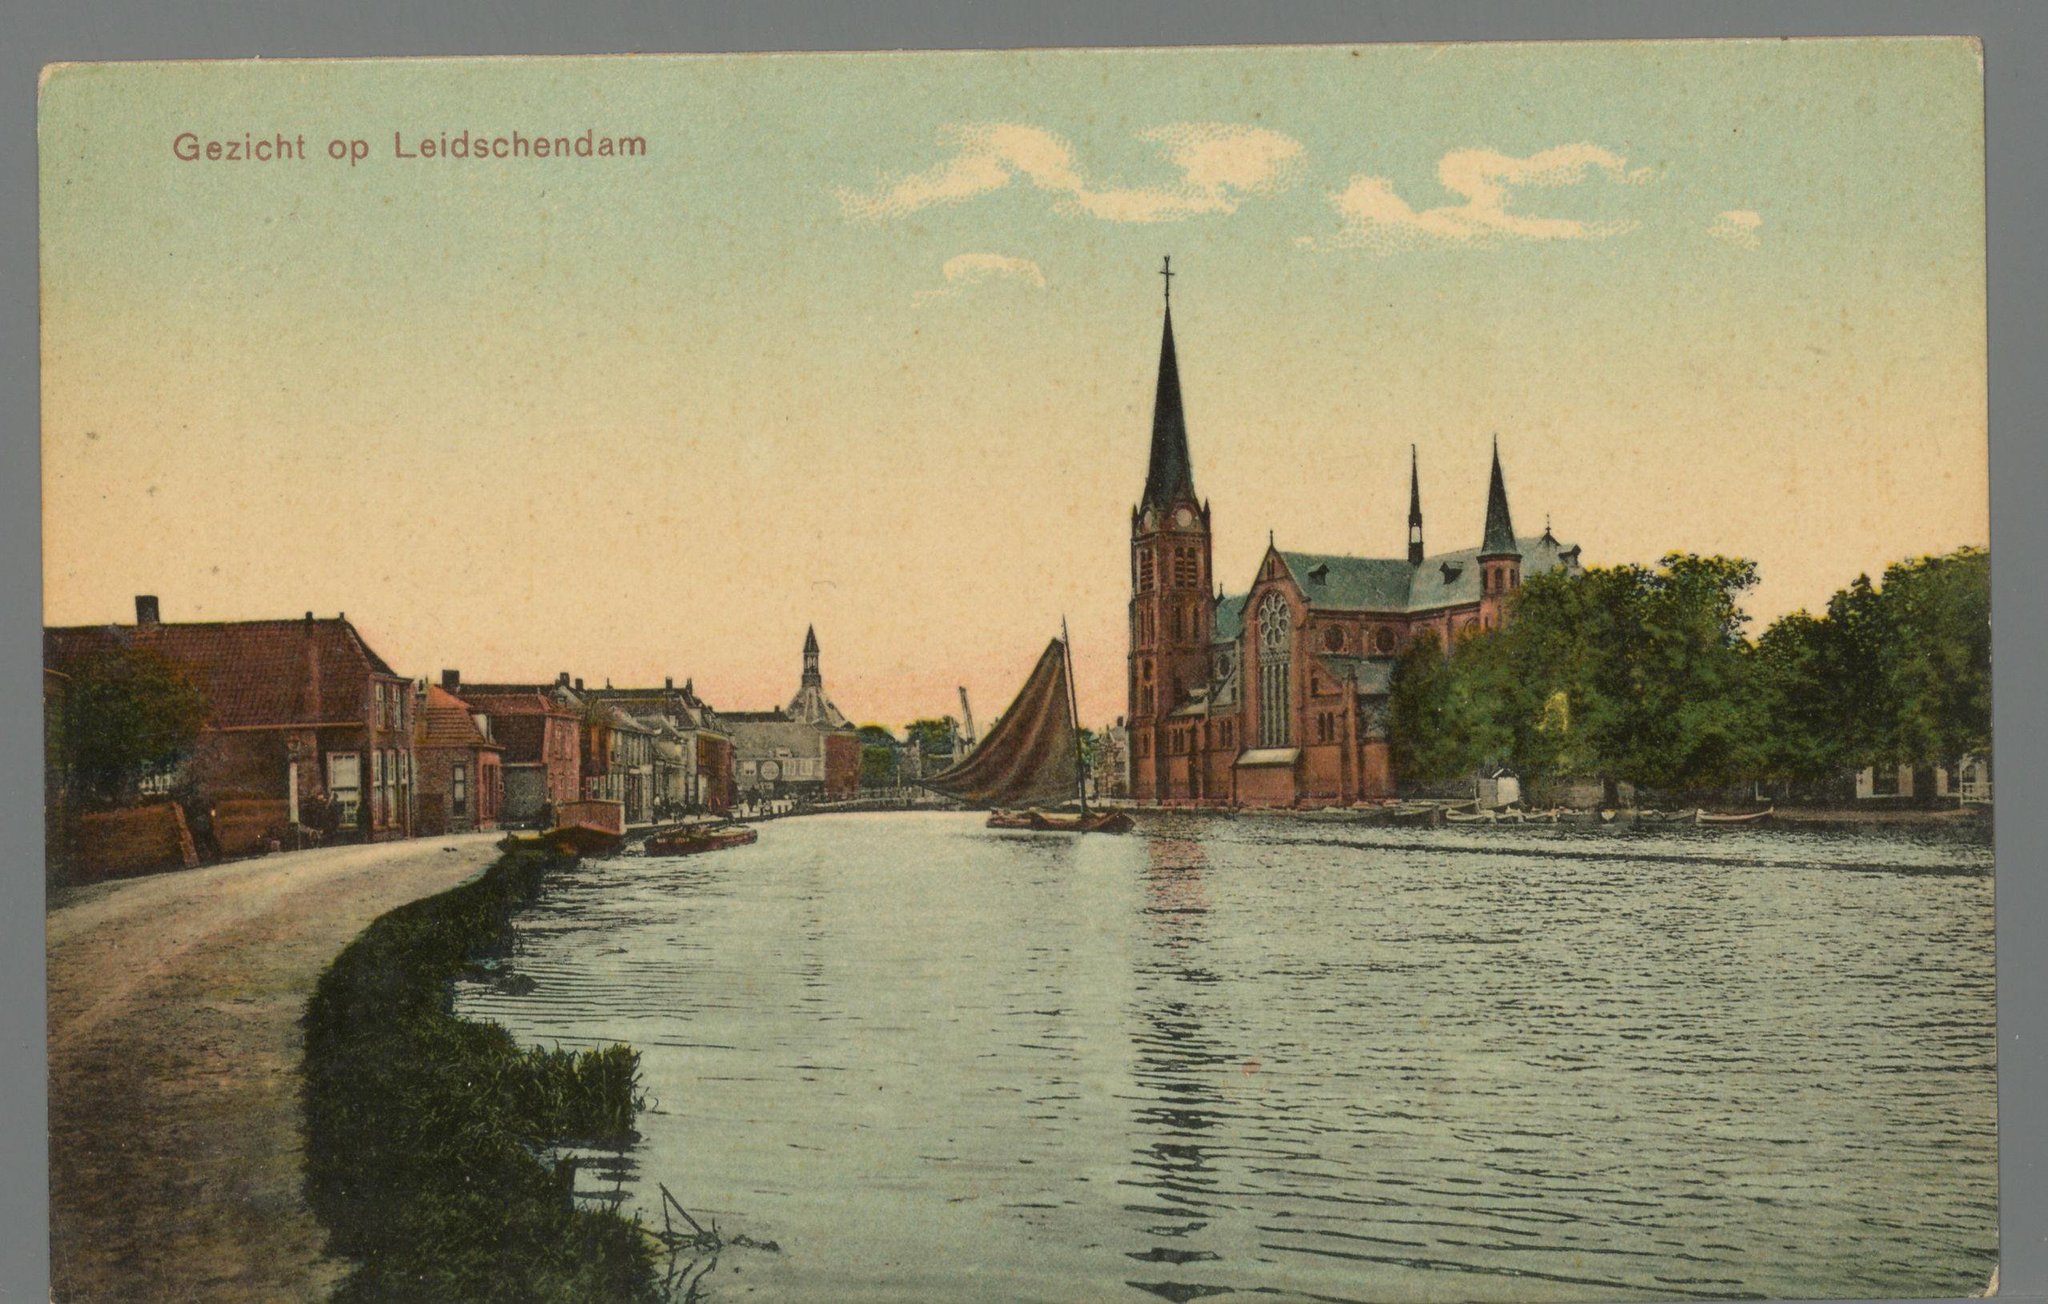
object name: ansichtkaart, prentbriefkaart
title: Gezicht op Leidschendam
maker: Anonymous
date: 1905-1930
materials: cardboard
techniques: photograph, lithograph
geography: leidschendam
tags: city-view, and landscape with man-made constructions, river, church (exterior)